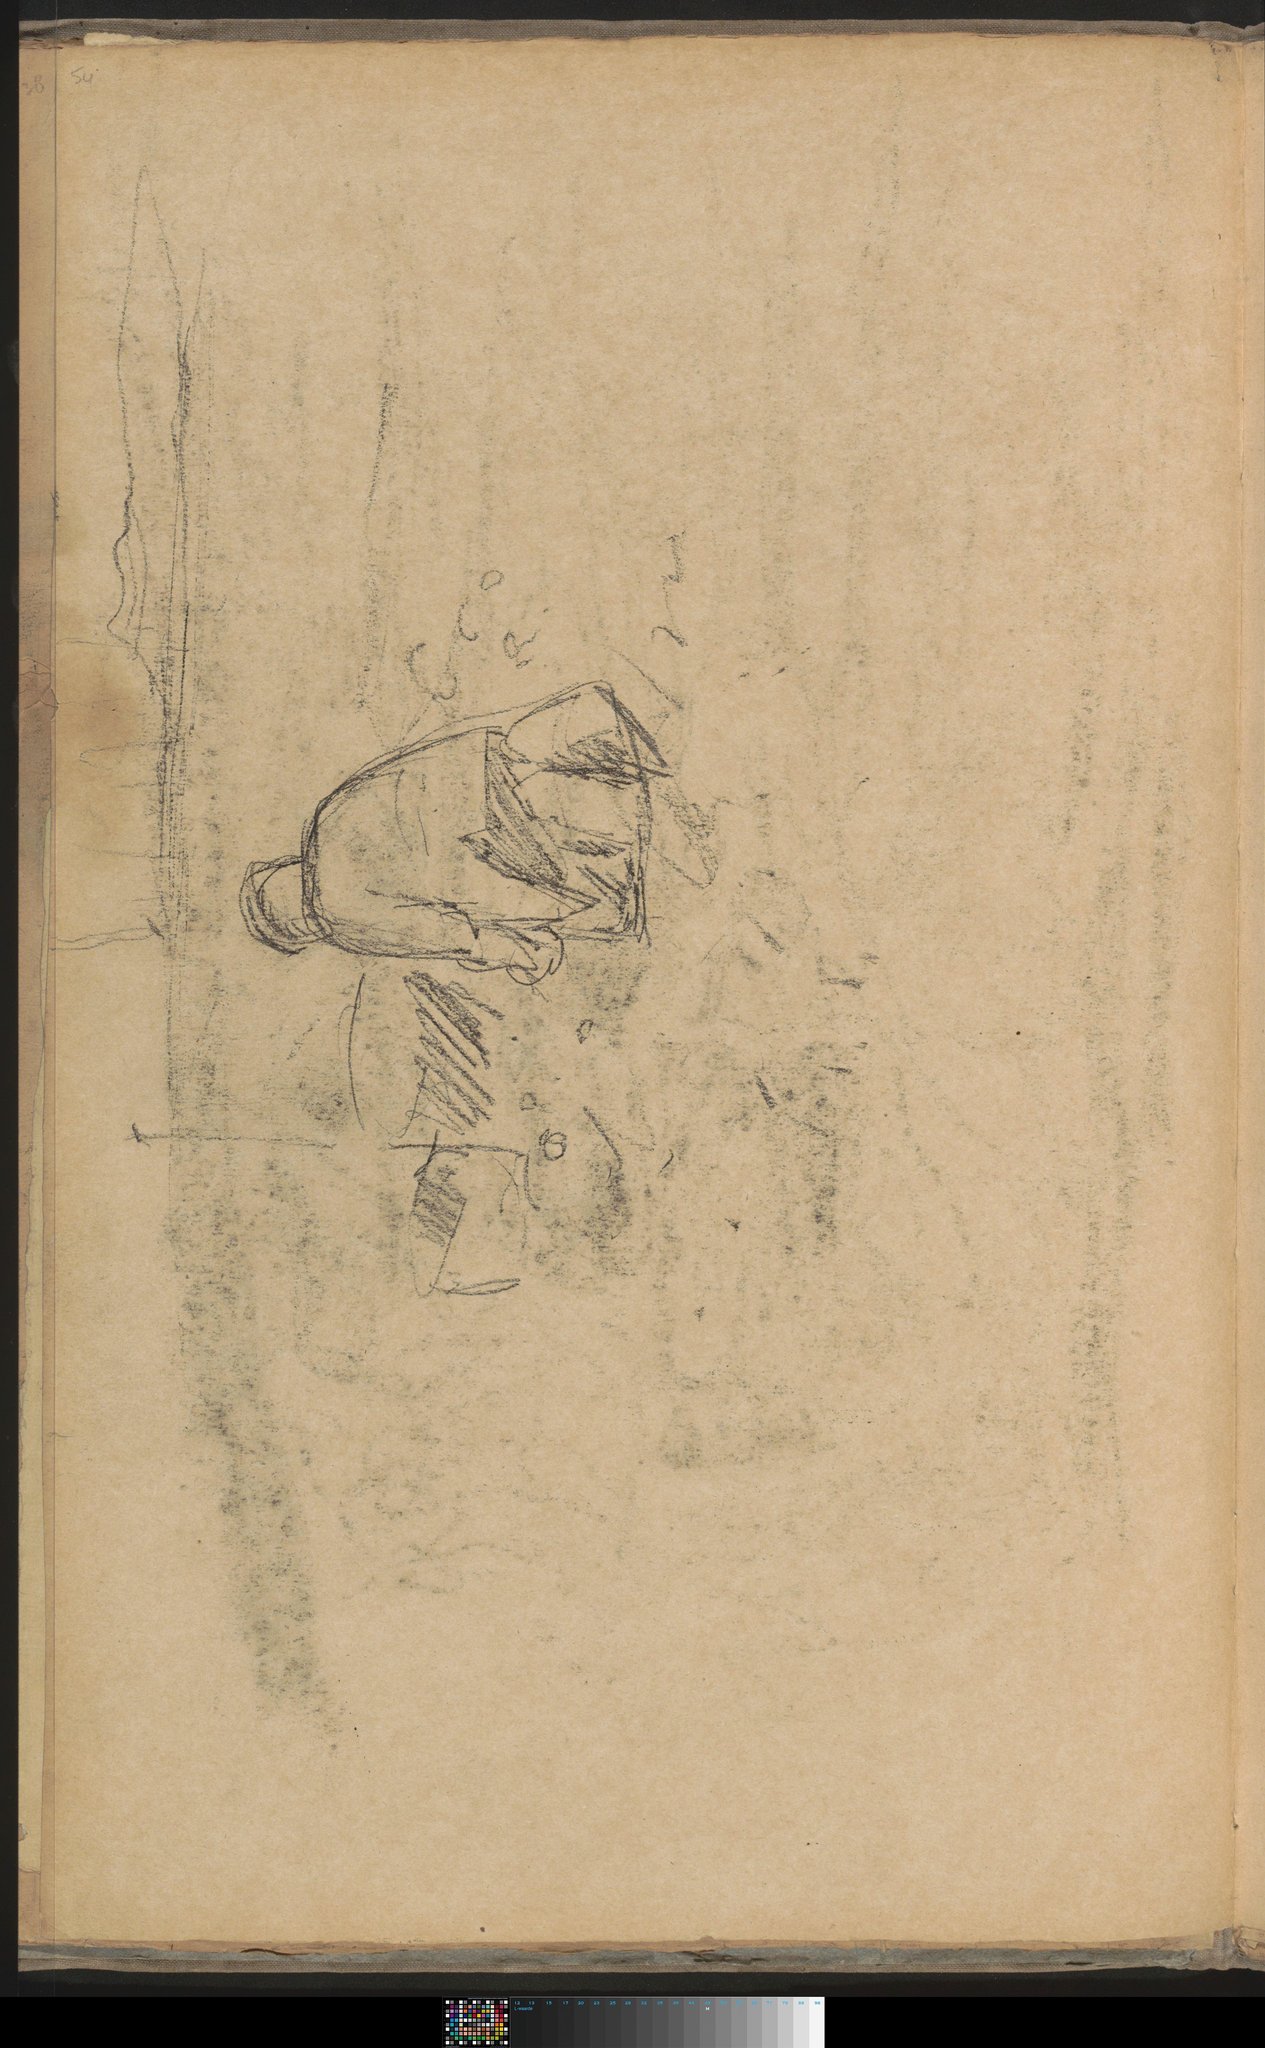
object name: sketchbook leaf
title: Geknielde boer, op de rug gezien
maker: willem witsen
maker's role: draughtsman, painter, print maker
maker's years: 1860-1923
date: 1884-1887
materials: chalk, paper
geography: ewijkshoeve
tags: kneeling figure (+ back view), farmers, reaping, picking, mowing ~ harvest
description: Hij rooit mogelijk aardappelen. Pagina 54 uit een schetsboek met 42 bladen vervaardigd rond de Ewijkshoeve.